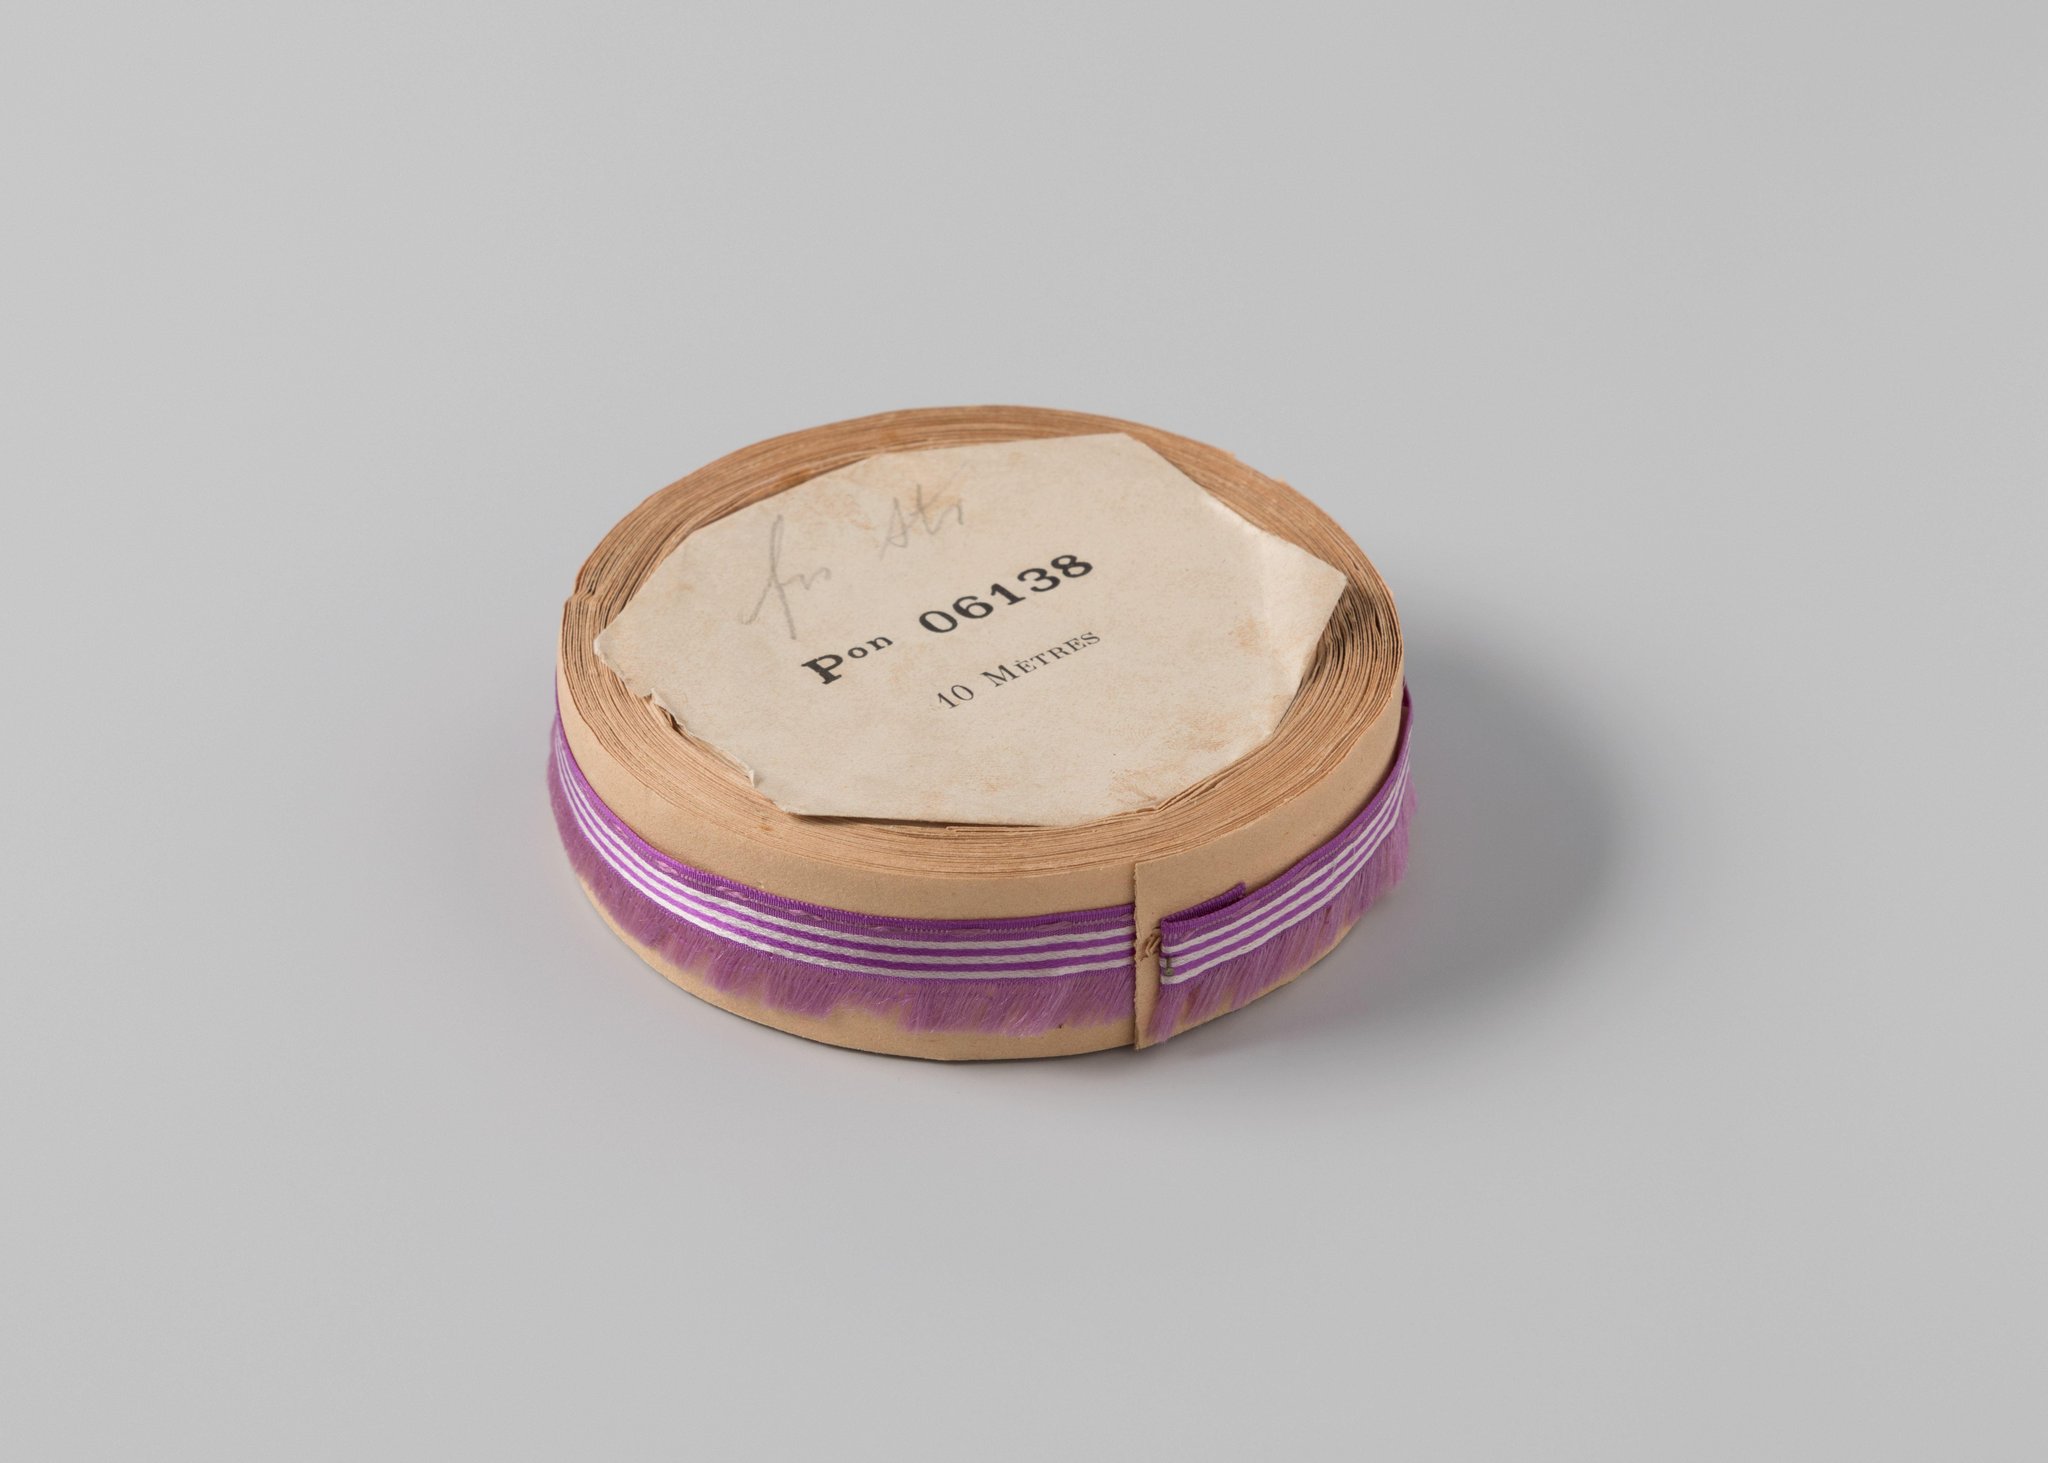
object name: braid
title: Rol met paars lint met één gerafelde zijde en drie witte horizontale strepen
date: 1935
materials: cardboard, paper, textile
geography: france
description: Rol met paars lint met één gerafelde zijde en drie witte horizontale strepen.